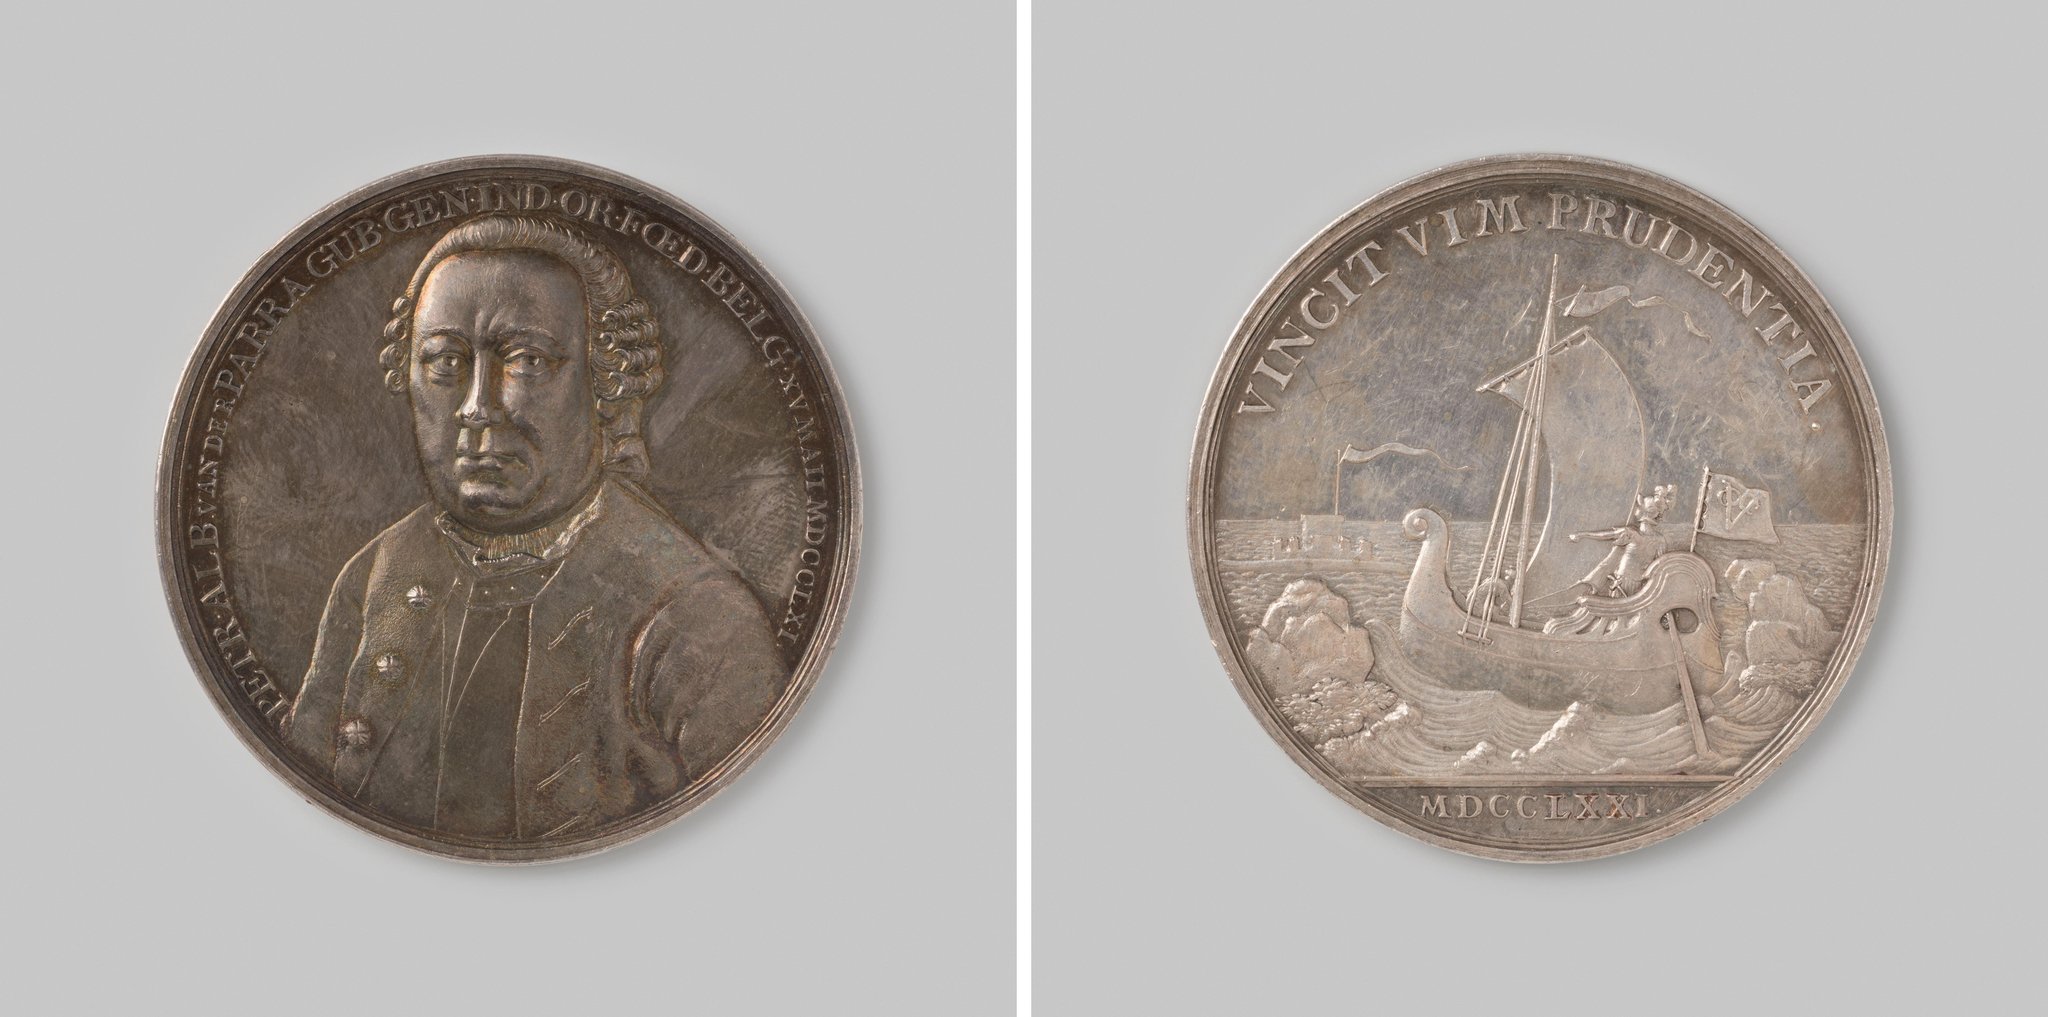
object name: history medal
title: Pieter Albert van der Parra tien jaar Gouverneur-generaal van Nederlands Indië 1771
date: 1771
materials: silver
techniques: pressing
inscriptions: exergue: ‘MDCCXXI.’, circumscription: ‘VINCIT VIM PRUDENTIA.’, circumscription: ‘PETR. ALB. VAN DER PARRA GUB. GEN. IND. OR. F˜ŒD. BELG. XV MAII MDCCLXI.’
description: Zilveren penning, op de voorzijde het borstbeeld van Van der Parra met omschrift, op de keerzijde een antiek schip met VOC-vlag dat temidden van rotsen naar zijn bestemming koerst, met omschrift en afsnedetekst.